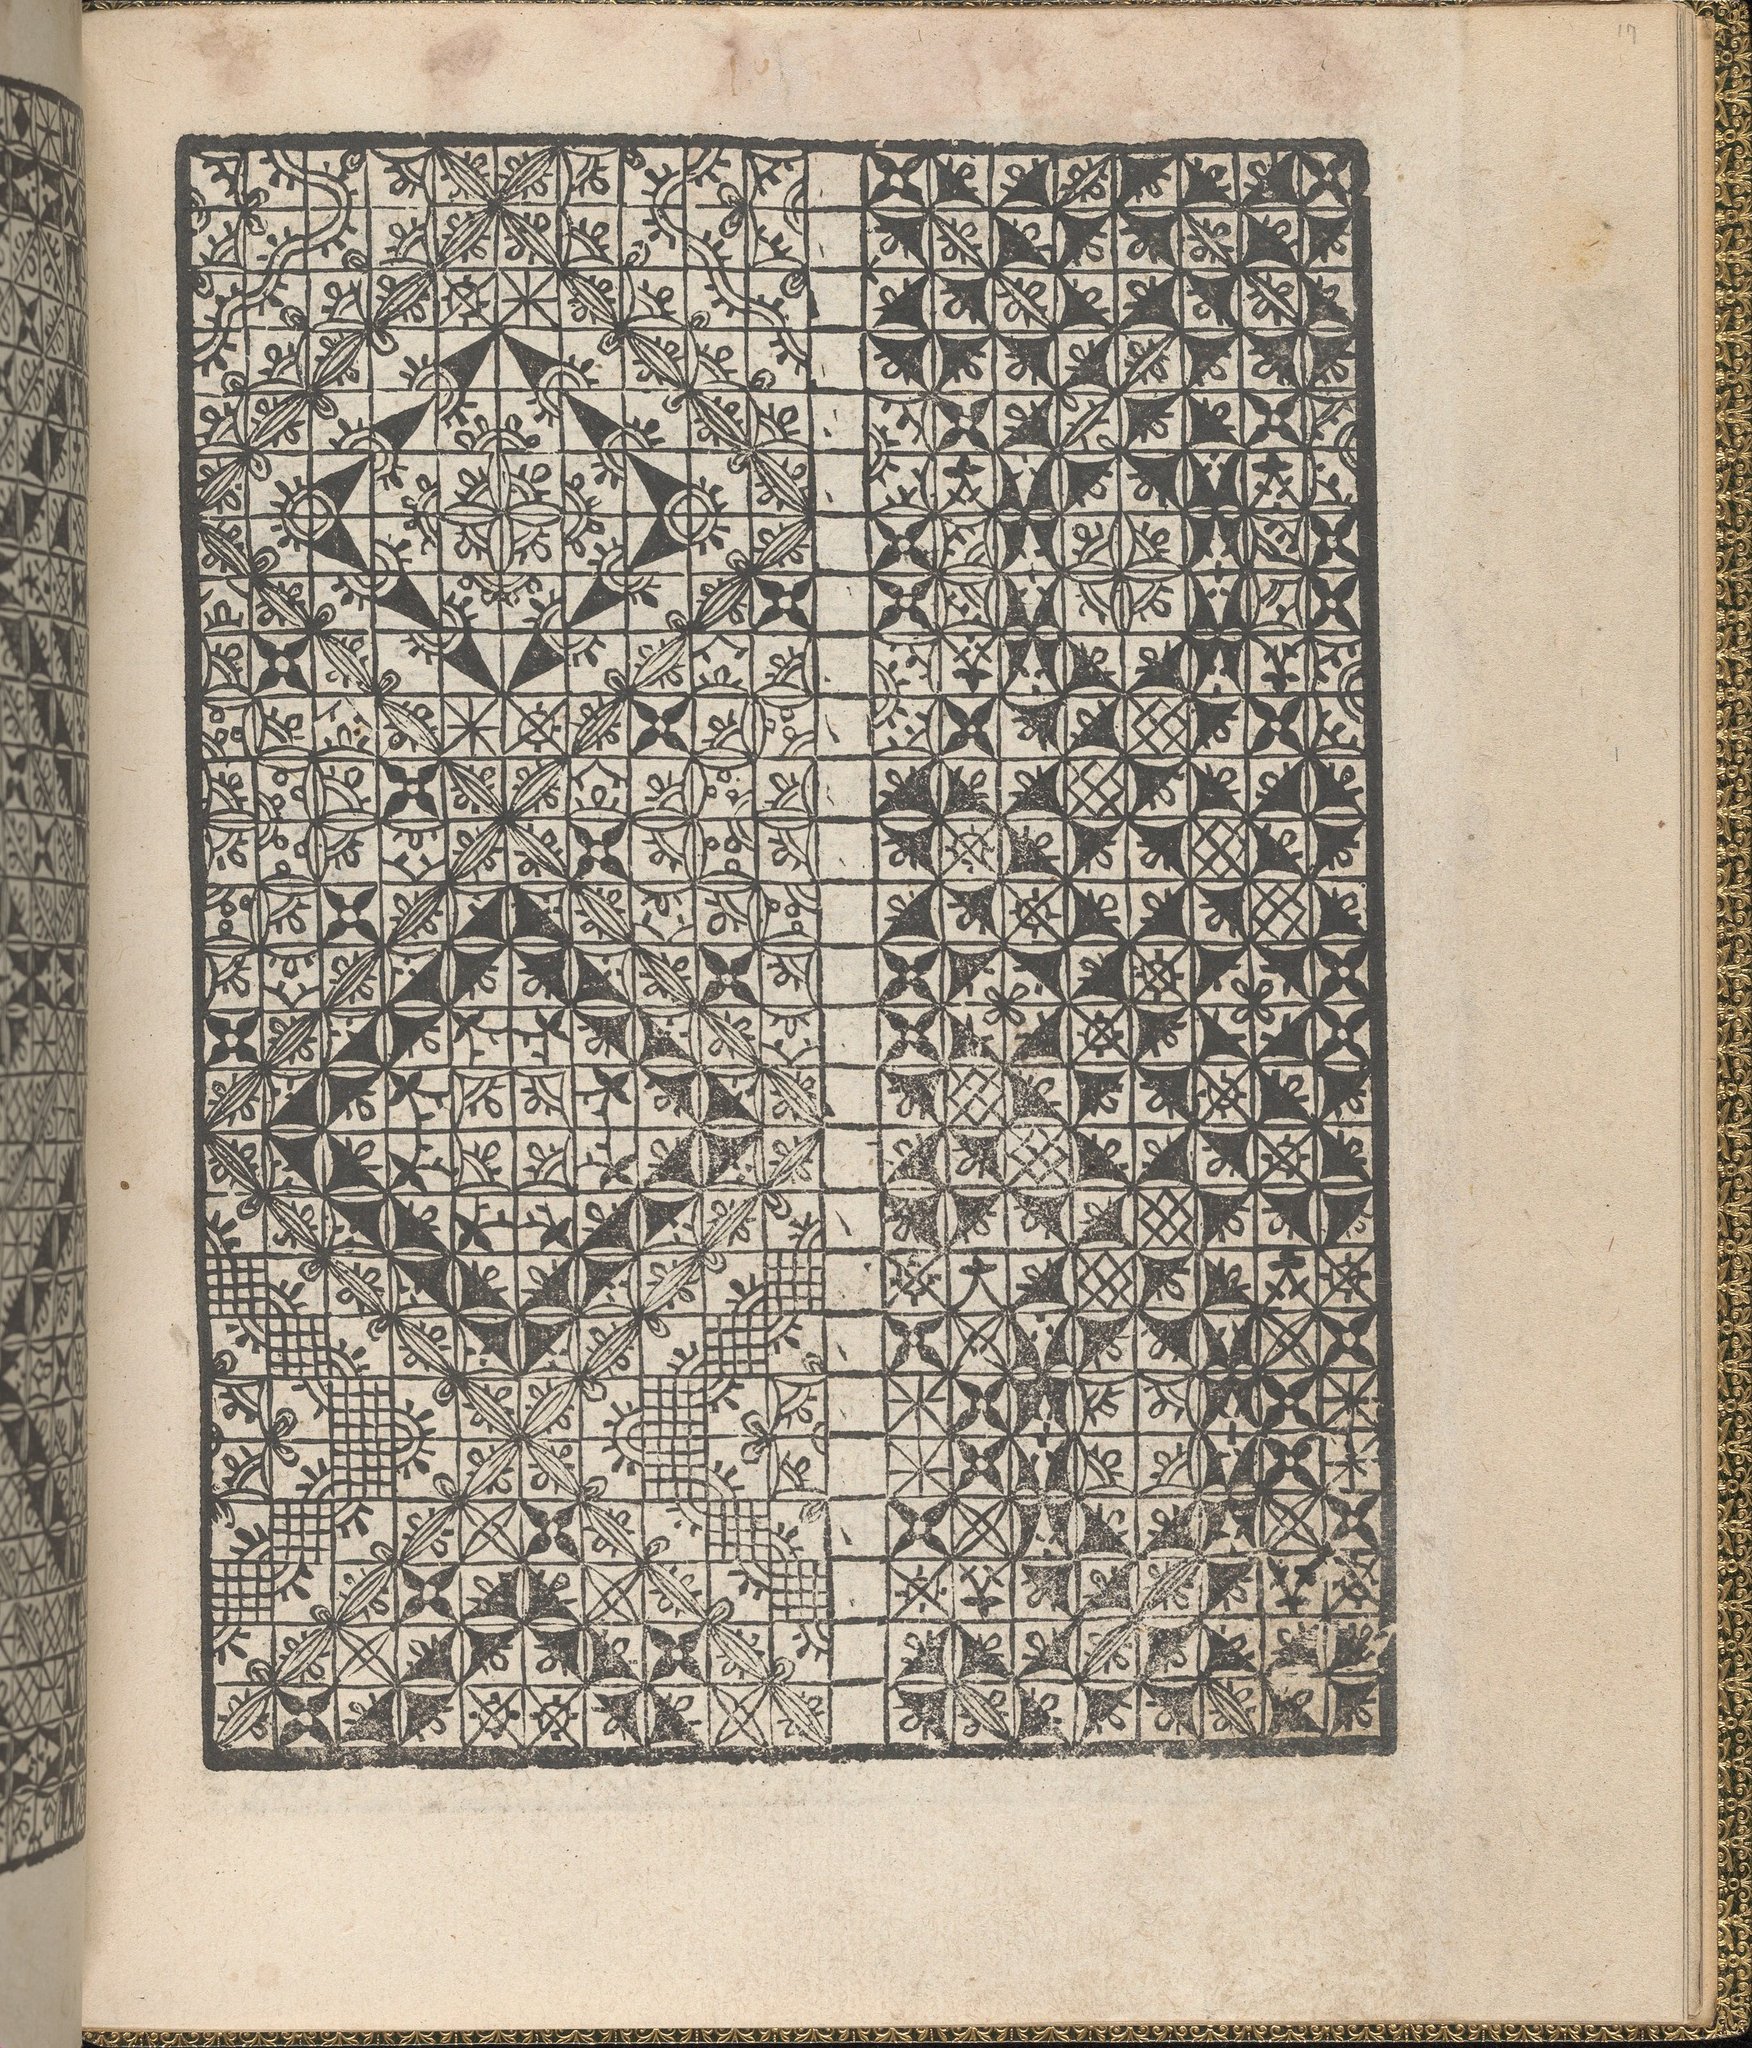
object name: book print ornament architecture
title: Giardineto novo di punti tagliati et gropposi per exercitio & ornamento delle donne (Venice 1554), page 9 (verso)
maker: matteo pagano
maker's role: publisher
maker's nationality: italian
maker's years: 1515-1588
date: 1554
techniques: woodcut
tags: ornament